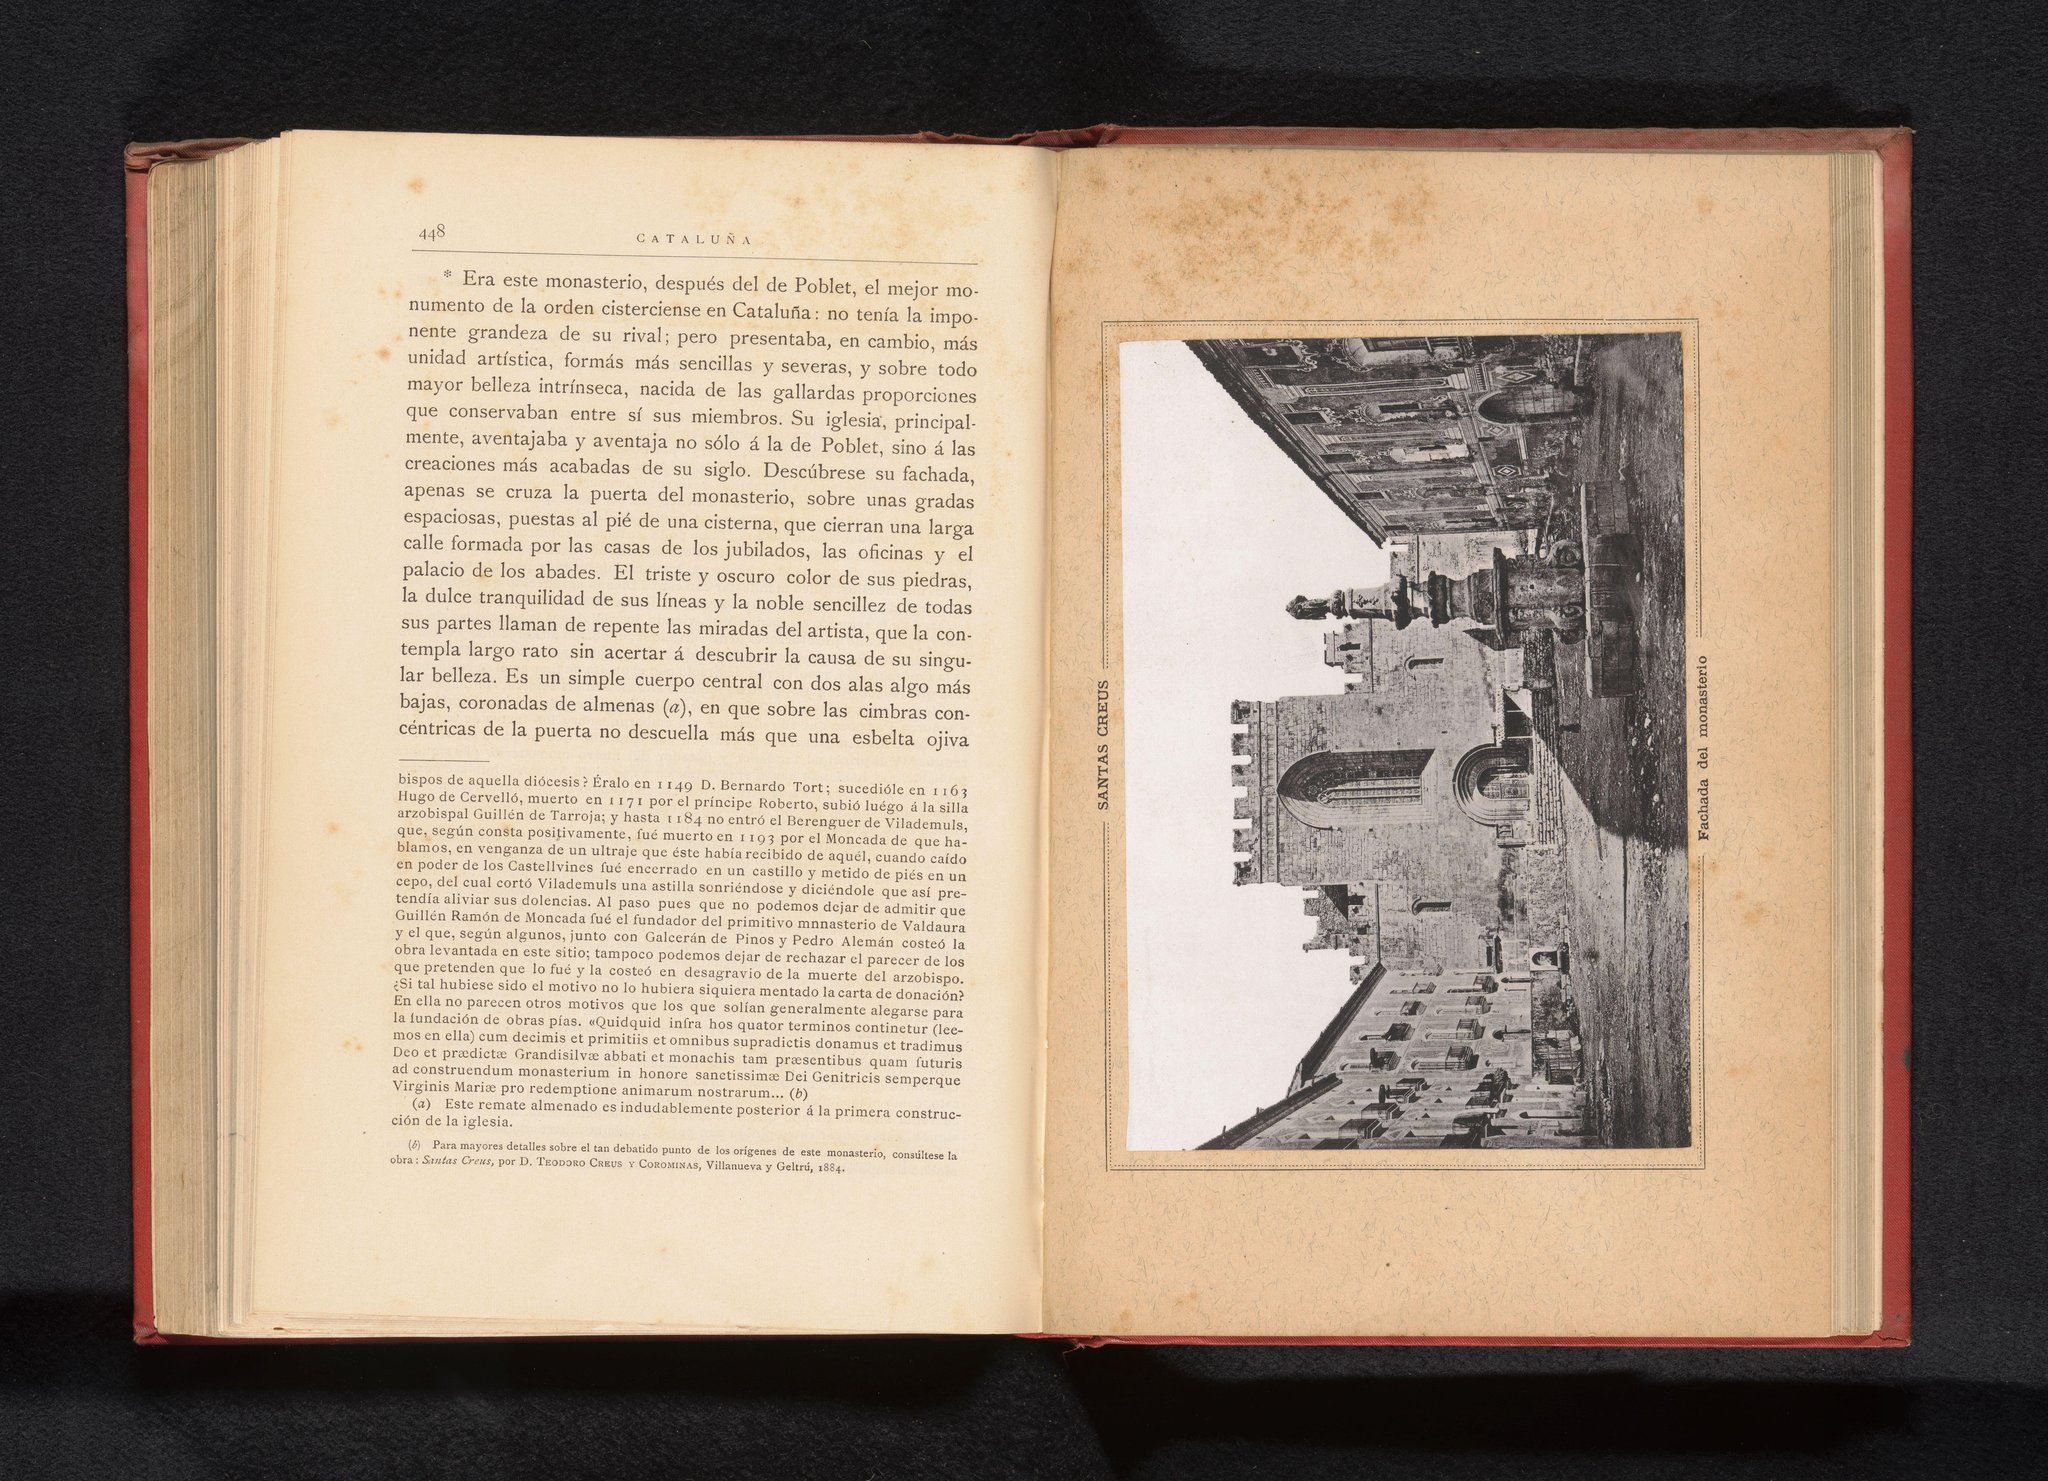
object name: photomechanical print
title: Fachada del monasterio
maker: Anonymous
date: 1874-1884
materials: paper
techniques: photograph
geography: aiguamúrcia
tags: abbey, monastery, convent ~ roman catholic church